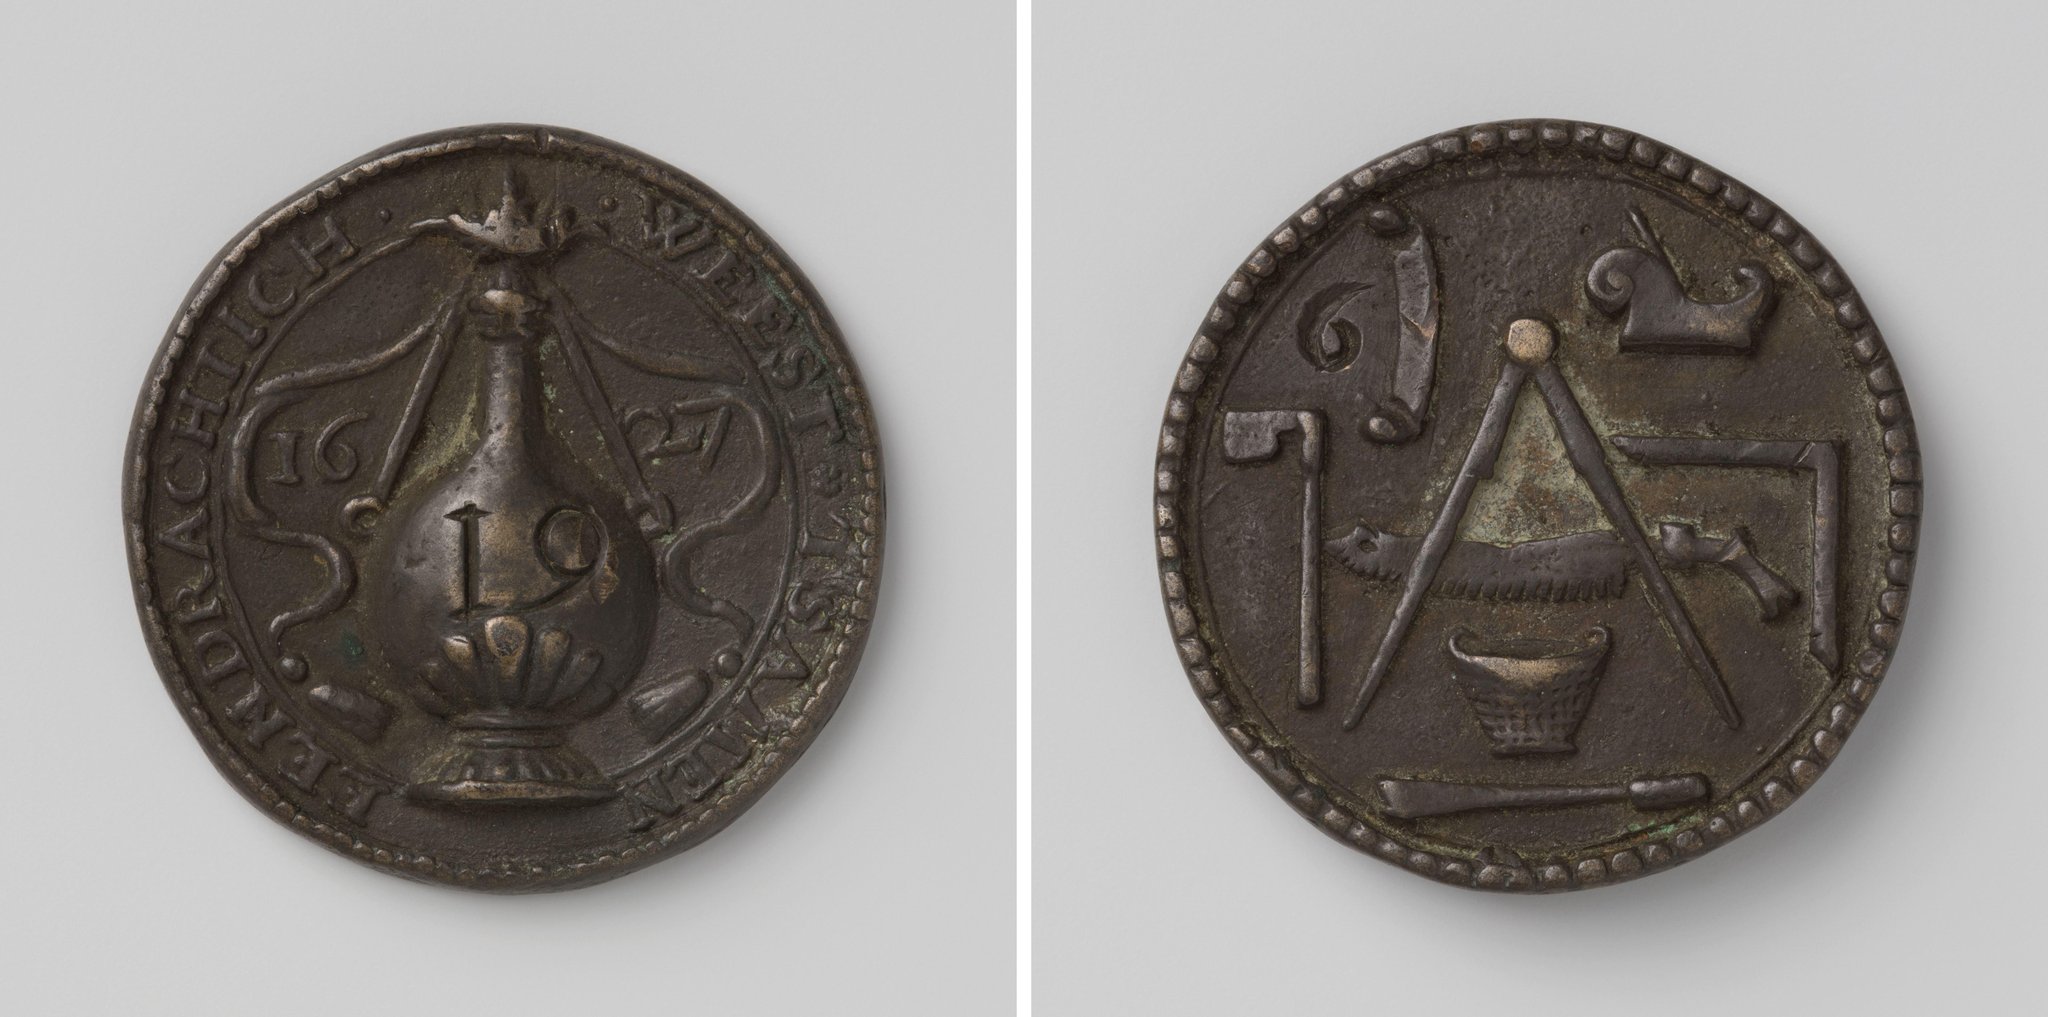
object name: medal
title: Timmerliedengilde van Vlissingen, gildepenning met no. 19 en no. 6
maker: johannes looff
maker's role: die cutter, draughtsman, print maker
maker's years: -1651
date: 1627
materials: brass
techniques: casting, engraving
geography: flushing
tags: flushing